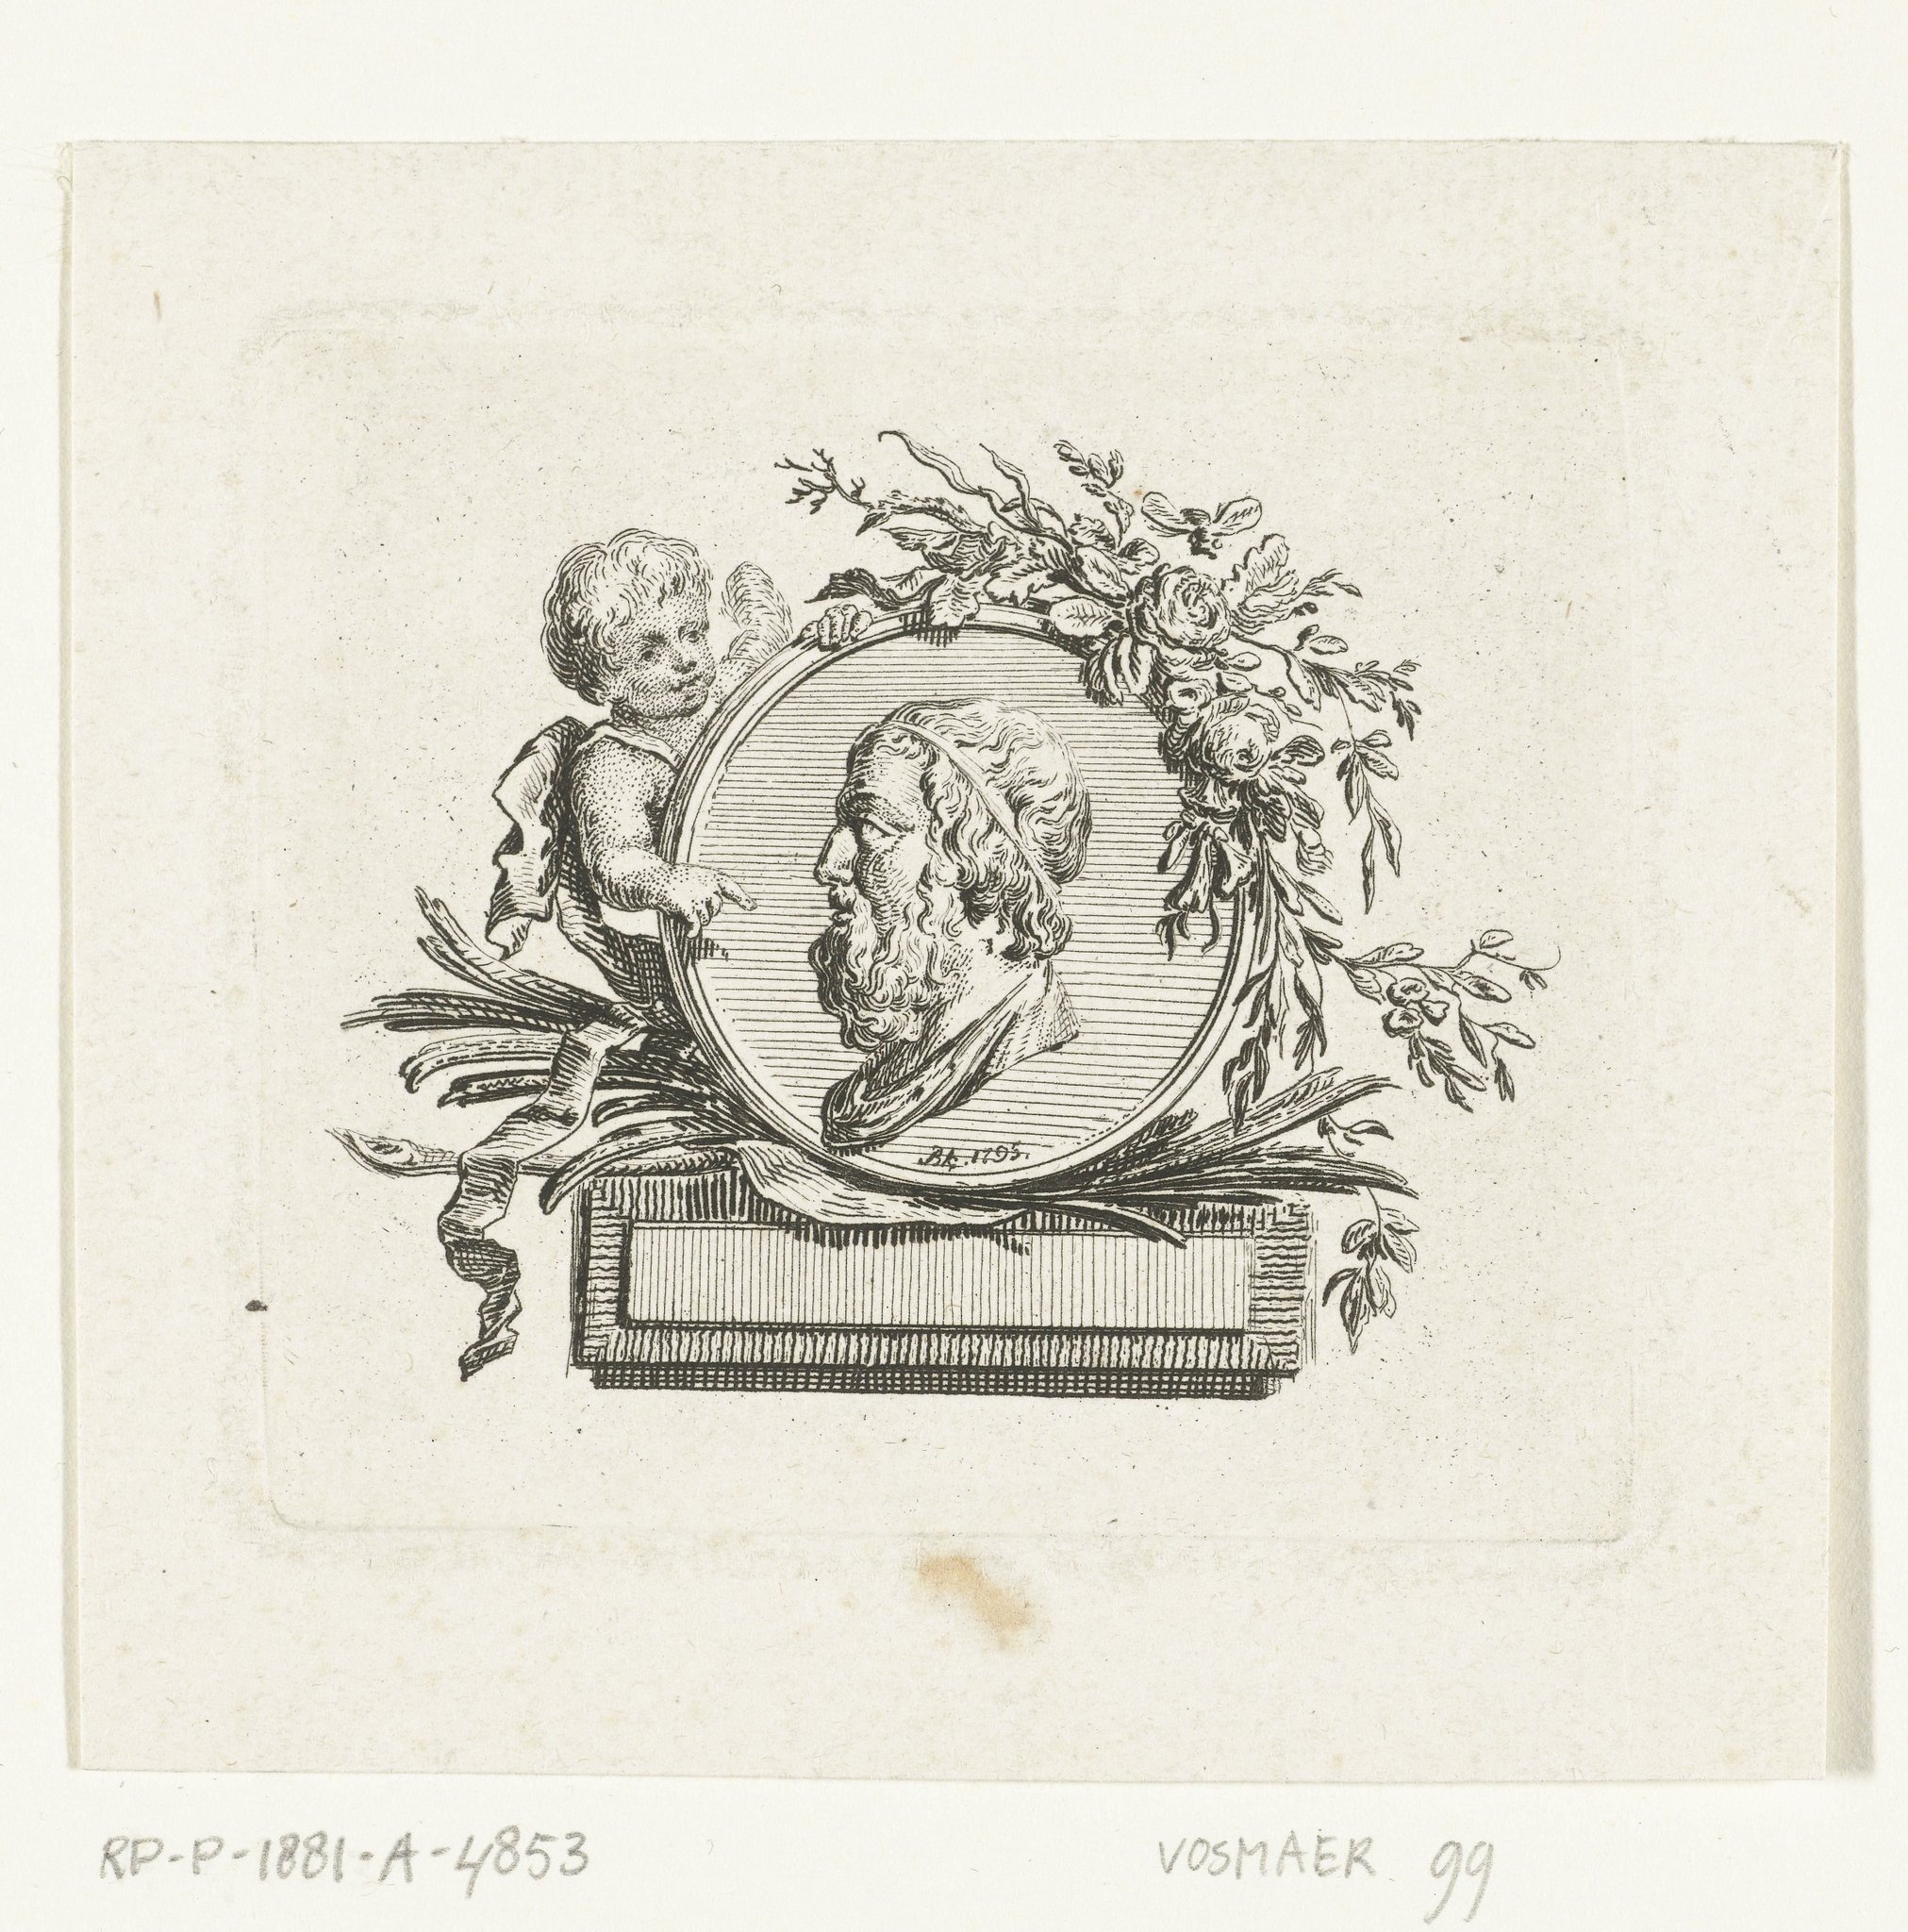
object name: print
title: Buste van Homerus op medaillon door engeltje vastgehouden en met bloemen en palmtakken versierd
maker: willem bilderdijk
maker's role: draughtsman, print maker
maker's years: 1756-1831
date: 1795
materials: paper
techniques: etching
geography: netherlands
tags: homerus, portrait of a writer, (story of) homer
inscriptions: collector's mark: Lugt 2228